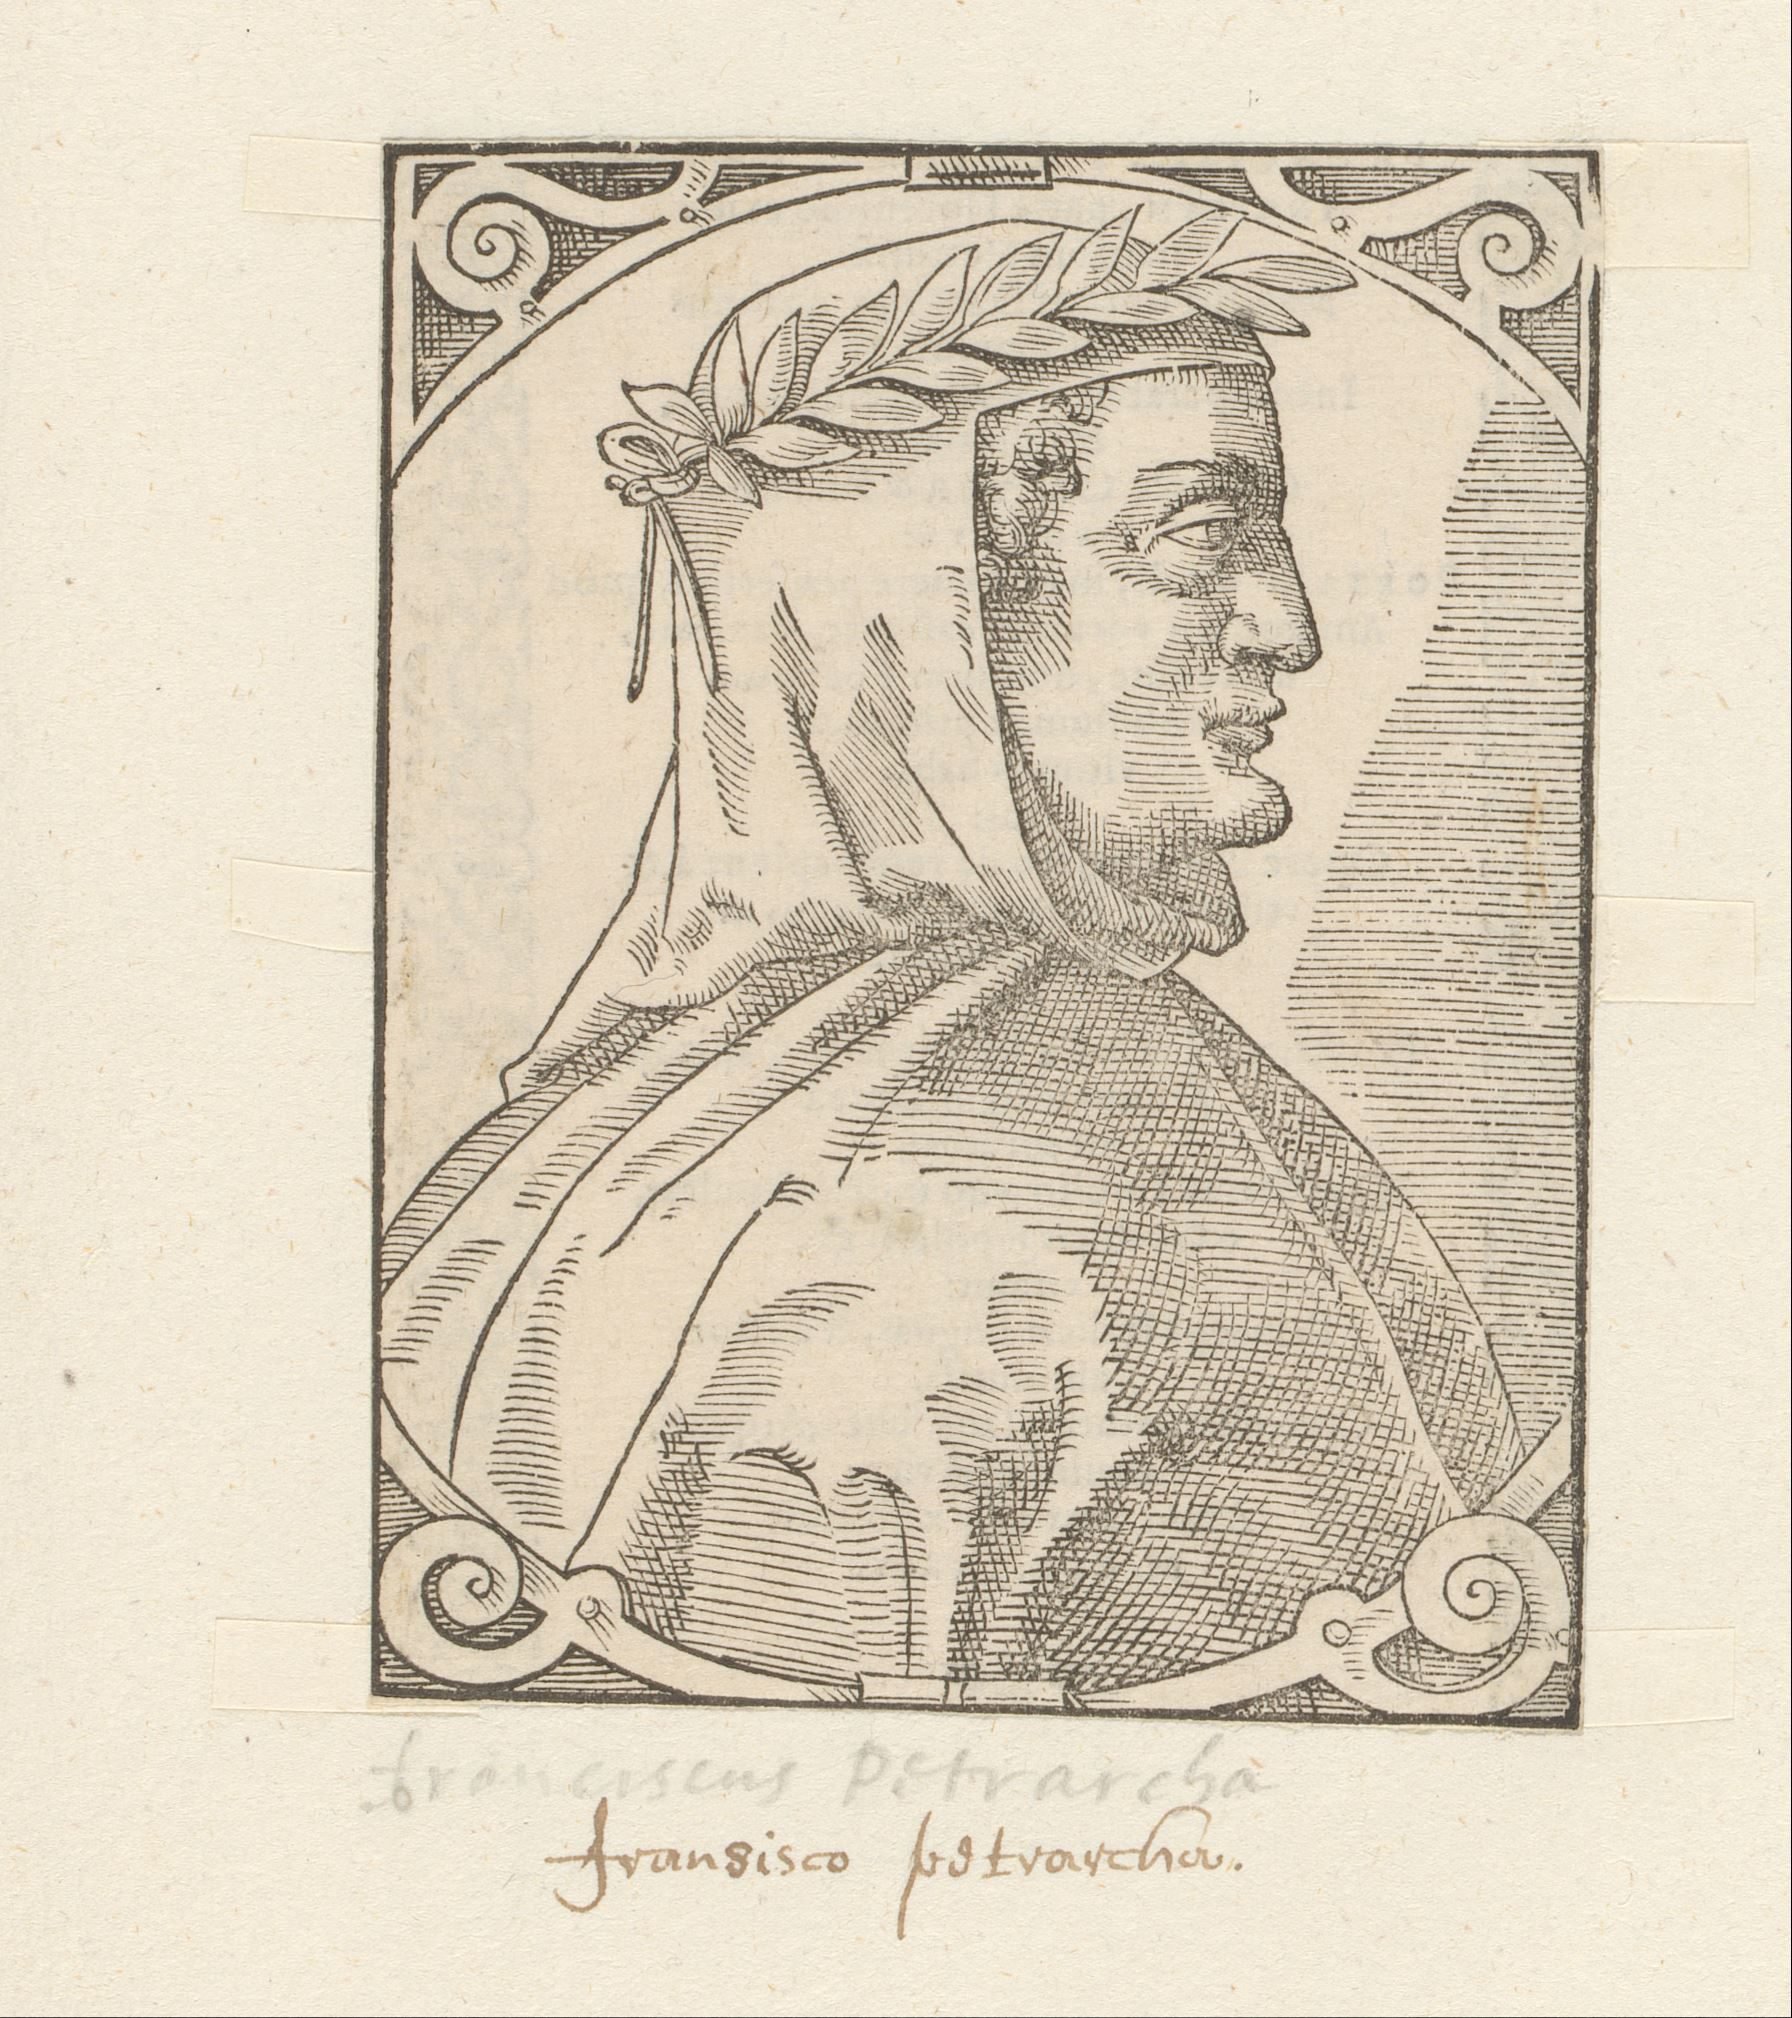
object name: book illustration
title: Portret van Francesco Petrarca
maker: Anonymous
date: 1549-1577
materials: paper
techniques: letterpress printing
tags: francesco petrarca, historical persons, writer, poet, author, scholar, philosopher (+ portrait of scholar, scientist)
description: Prent gebruikt in: Giovio, Paolo. Elogia Virorum literis illustrium (...). Bazel: Peter Perna, 1577.